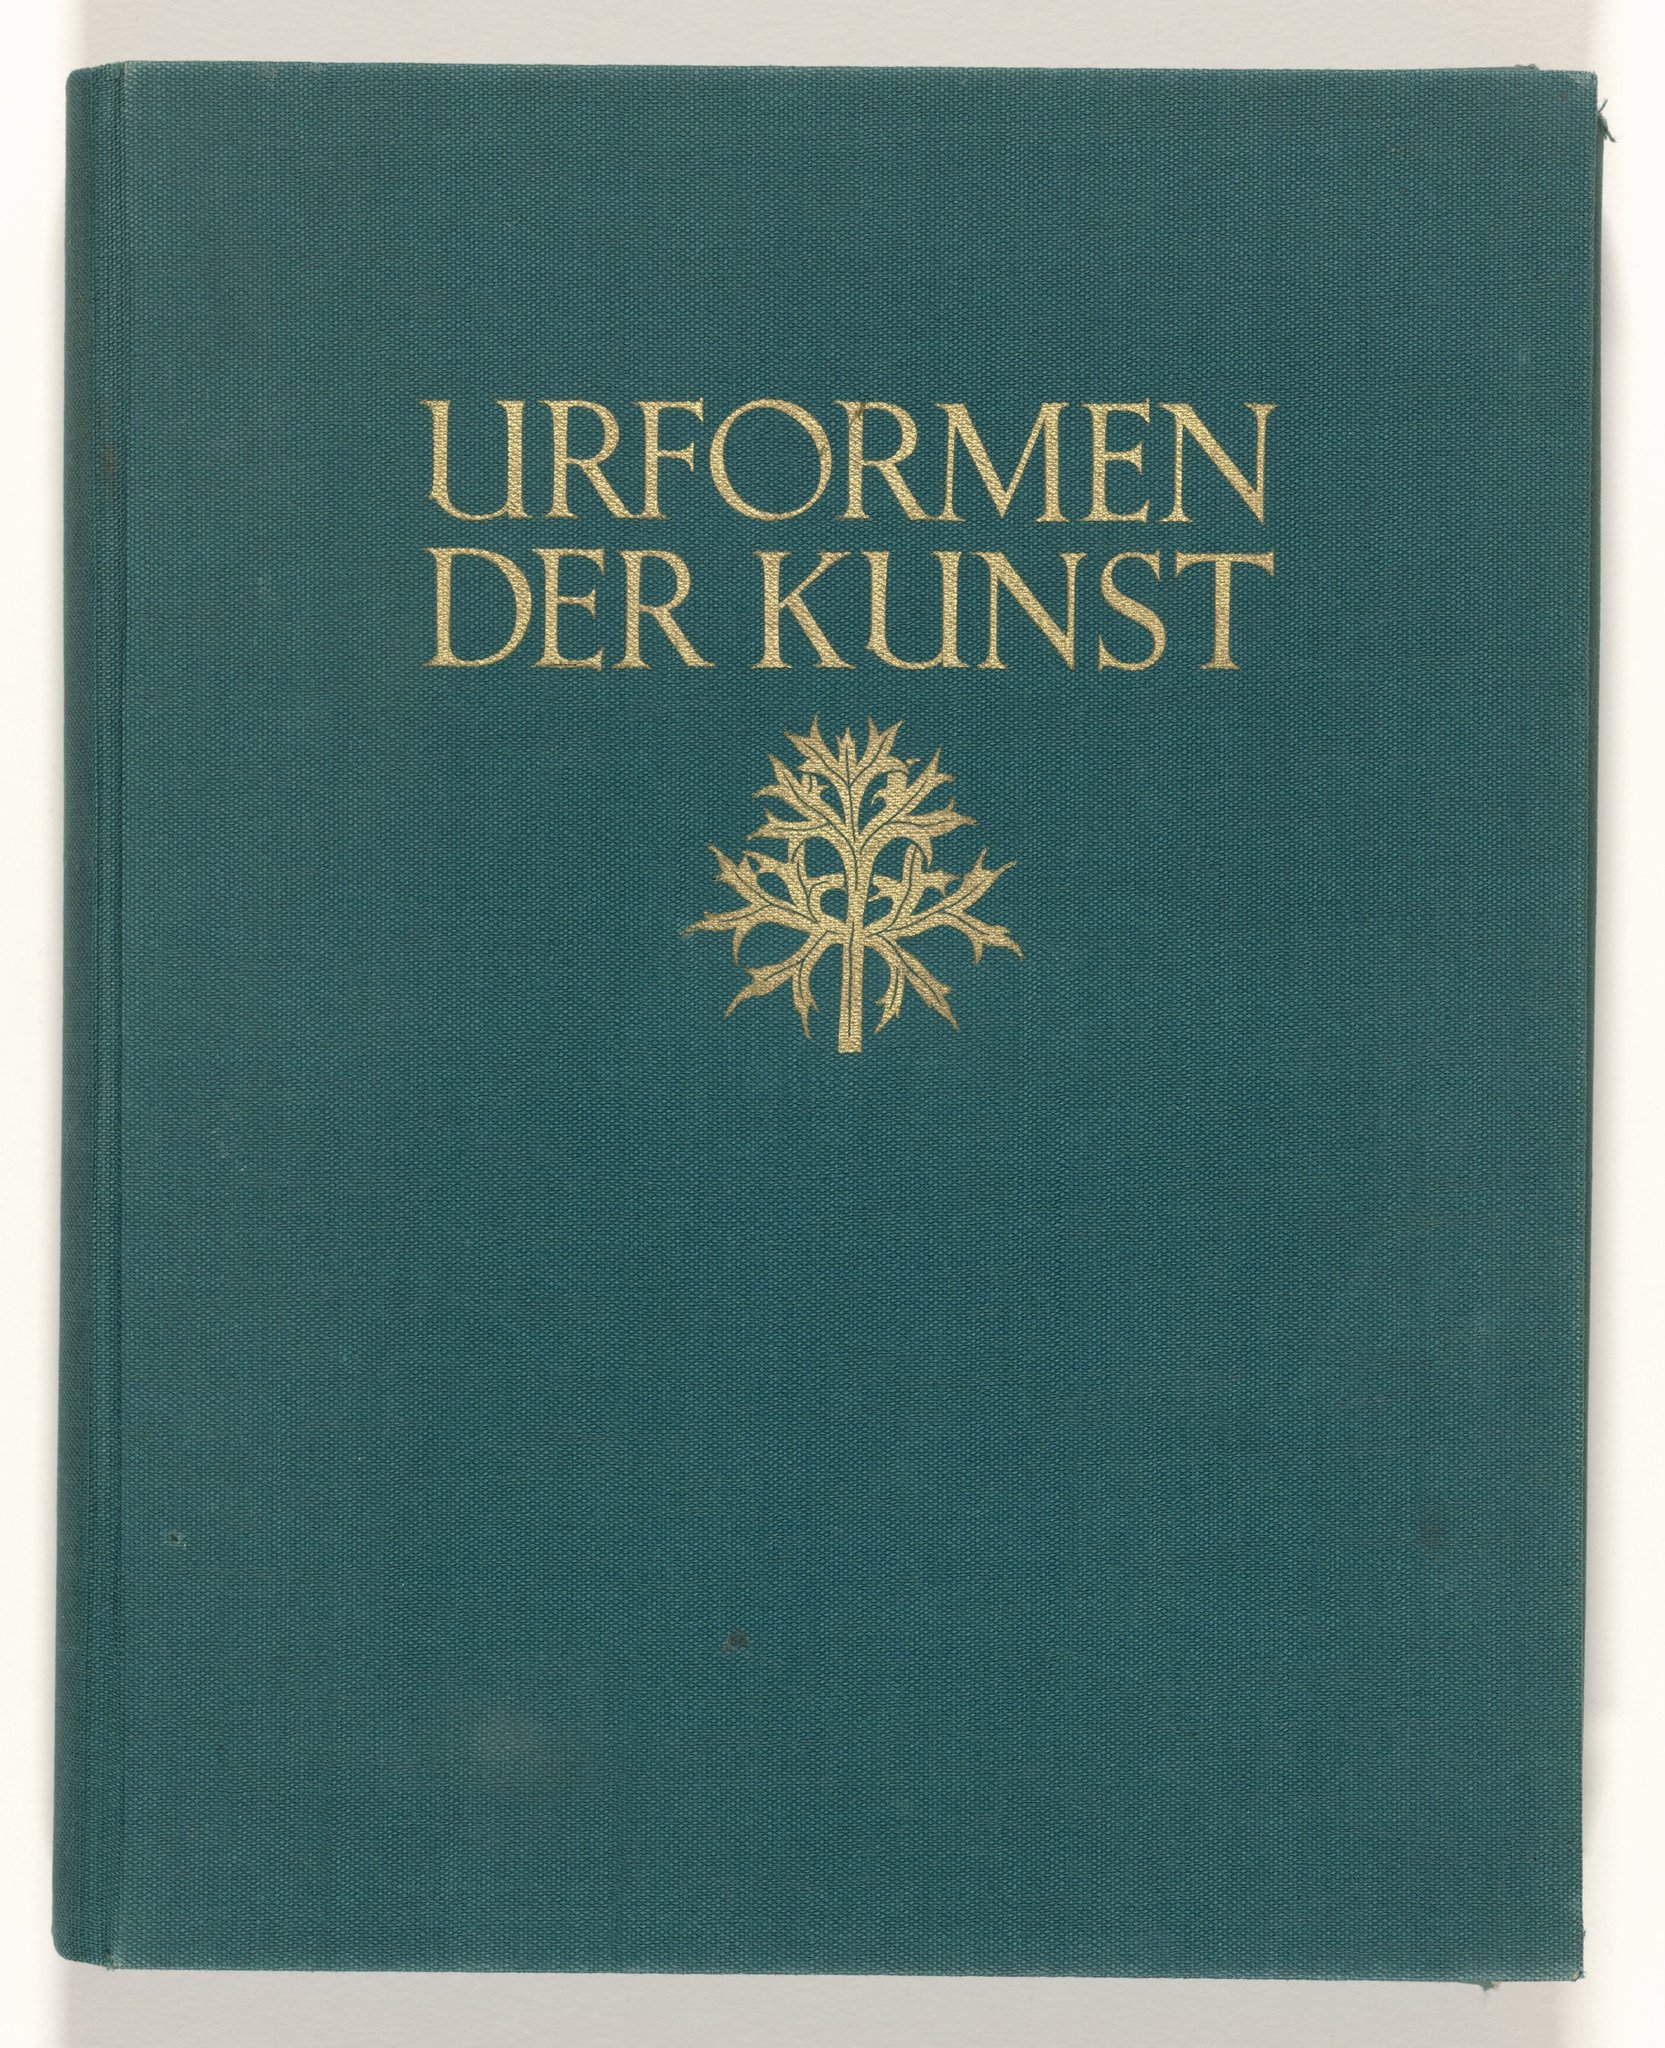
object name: photobook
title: Urformen der Kunst : photographische Pflanzenbilder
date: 1928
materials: ink, paper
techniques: rotogravure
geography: berlin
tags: plants (in general)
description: Losbladige uitgave van Urformen der Kunst.